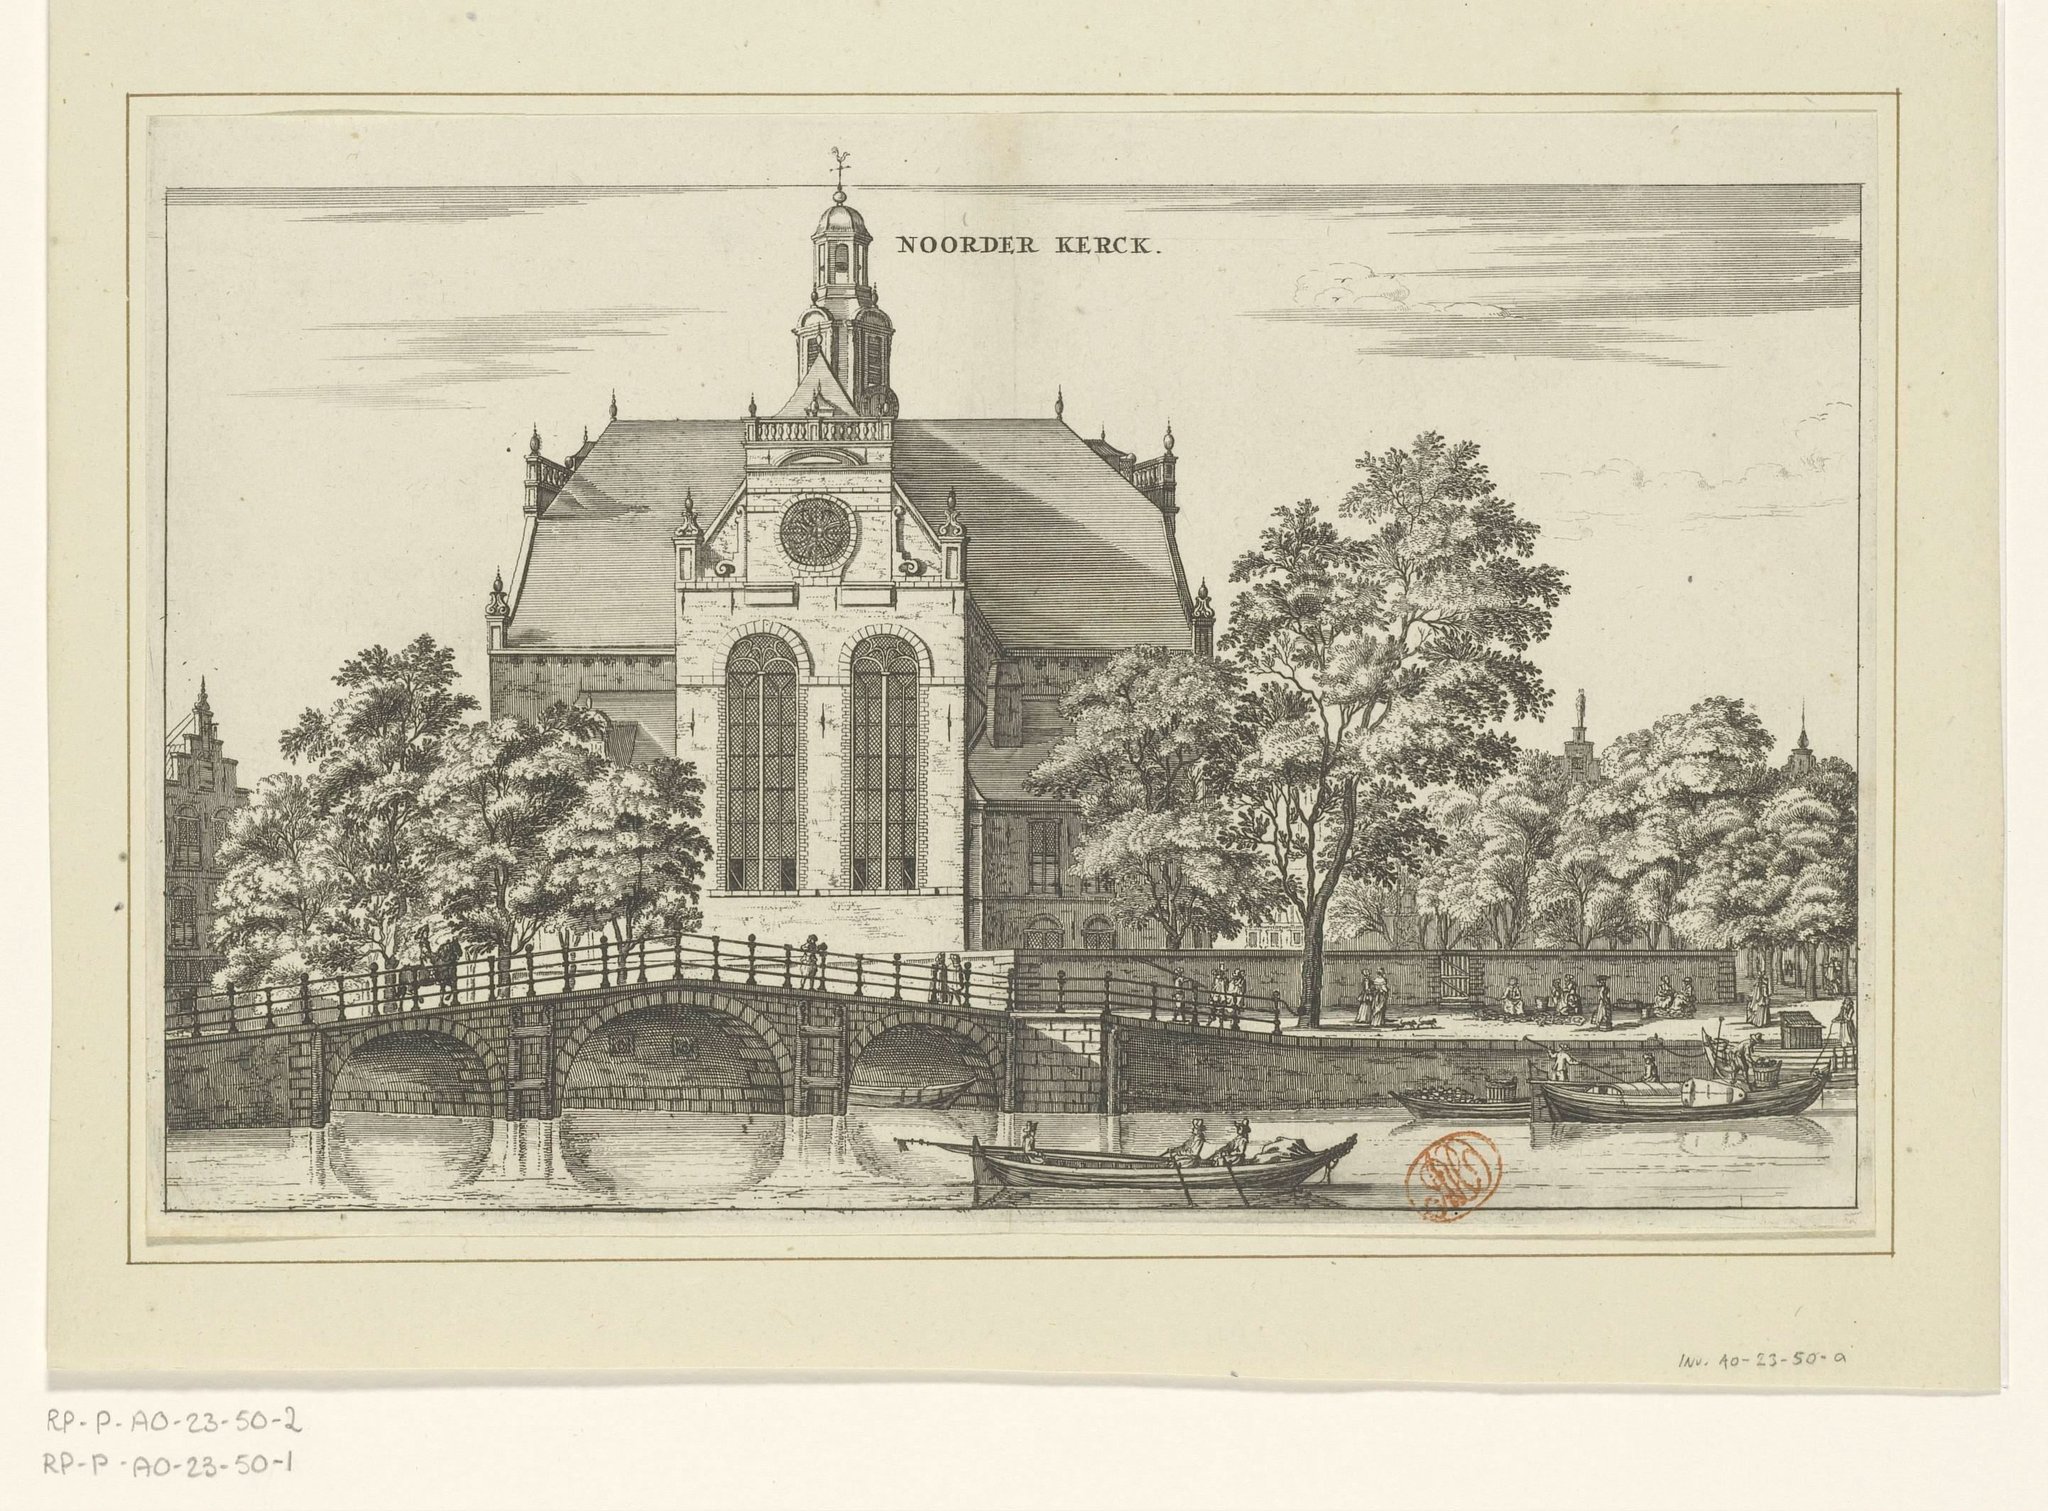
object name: print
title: Gezicht op de Noorderkerk te Amsterdam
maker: jacob van meurs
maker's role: draughtsman, print maker, publisher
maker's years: 1619-1680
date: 1663-1664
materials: paper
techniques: engraving, etching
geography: amsterdam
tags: ships (in general), church (exterior)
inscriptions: collector's mark: Lugt 195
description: Huidige staat van prent ook gebruikt in: Dapper, Olfert. Historische beschryving der stadt Amsterdam: waer in de voornaemste geschiedenissen (na een kort verhael van gansch Hollant en d'omleggende dorpen (…). Amsterdam: Jacob van Meurs, 1663.* En in: Zesen, Philipp von. Beschreibung der Stadt Amsterdam: darinnen von derselben ersten Ursprunge bis auf gegenwärtigen Zustand (…). Amsterdam: Joachim Nosche, 1664. * In sommige exemplaren van deze uitgave komt de huidige staat van de prent voor. In andere exemplaren is een latere staat ingebonden, waarop boven de Nederlandse een Franse titel is toegevoegd.